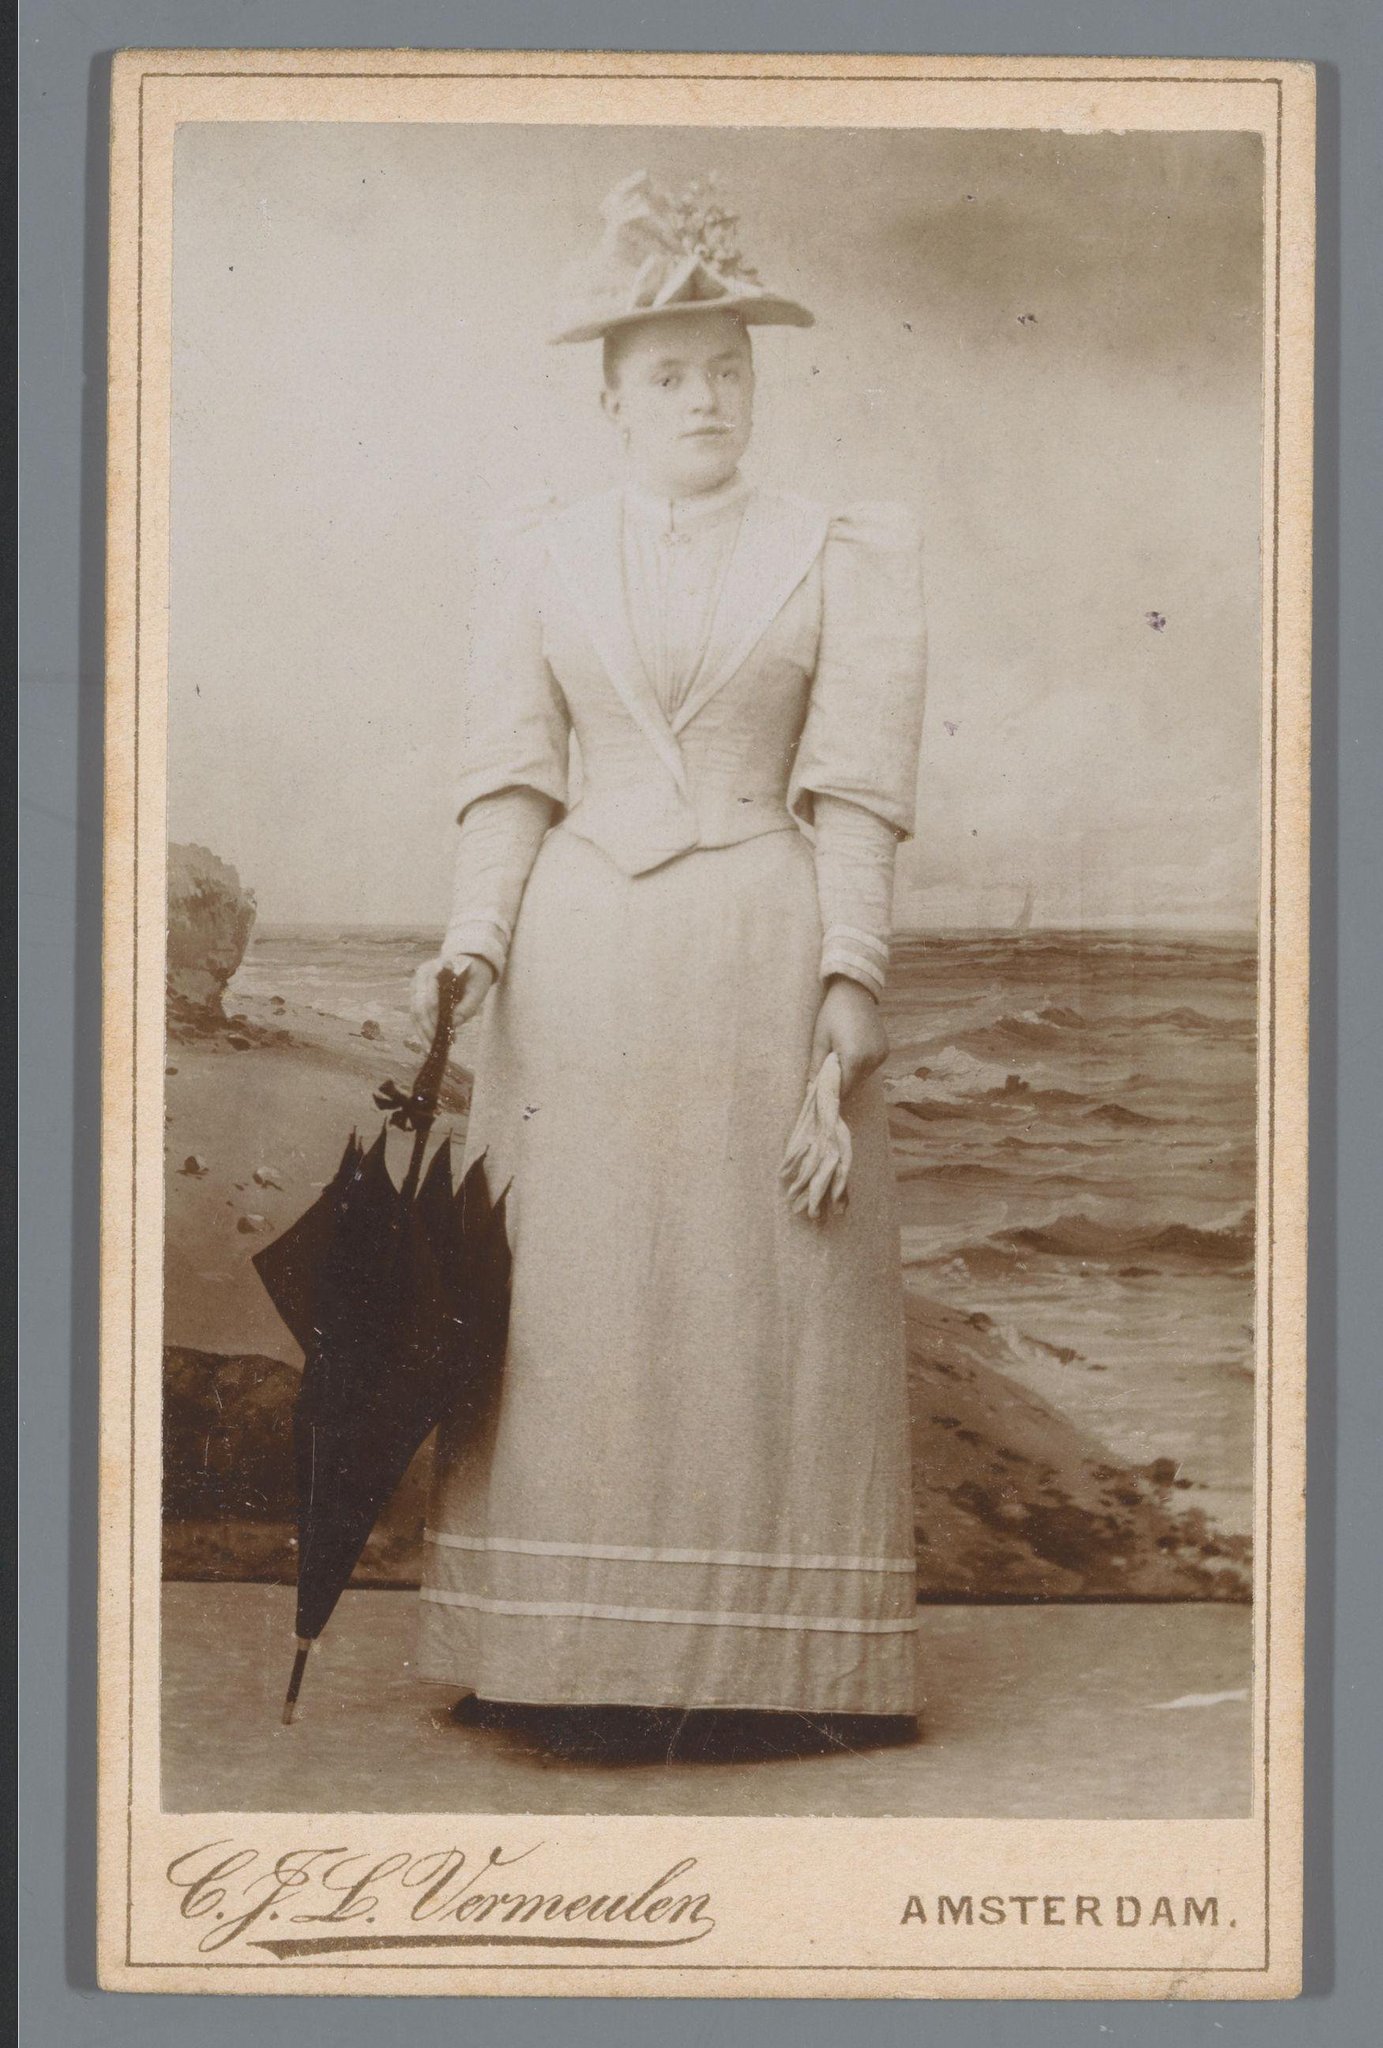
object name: photograph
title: Portret van een onbekende vrouw met een paraplu en handschoenen in haar hand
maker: cornelis johannes lodewicus vermeulen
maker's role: fotograaf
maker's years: 1861-1936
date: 1888-1896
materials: cardboard, photographic support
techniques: collodion silver print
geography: amsterdam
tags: historical persons - bb - woman, gloves, mittens, etc., umbrella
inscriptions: inscription: ‘Photographische/ ATELIERS/ C. J. L. Vermeulen/ Heerenstraat 6,/ Heiligenweg/ hoek Singel/ AMSTERDAM,/ Specialiteit in vergrootingen.’